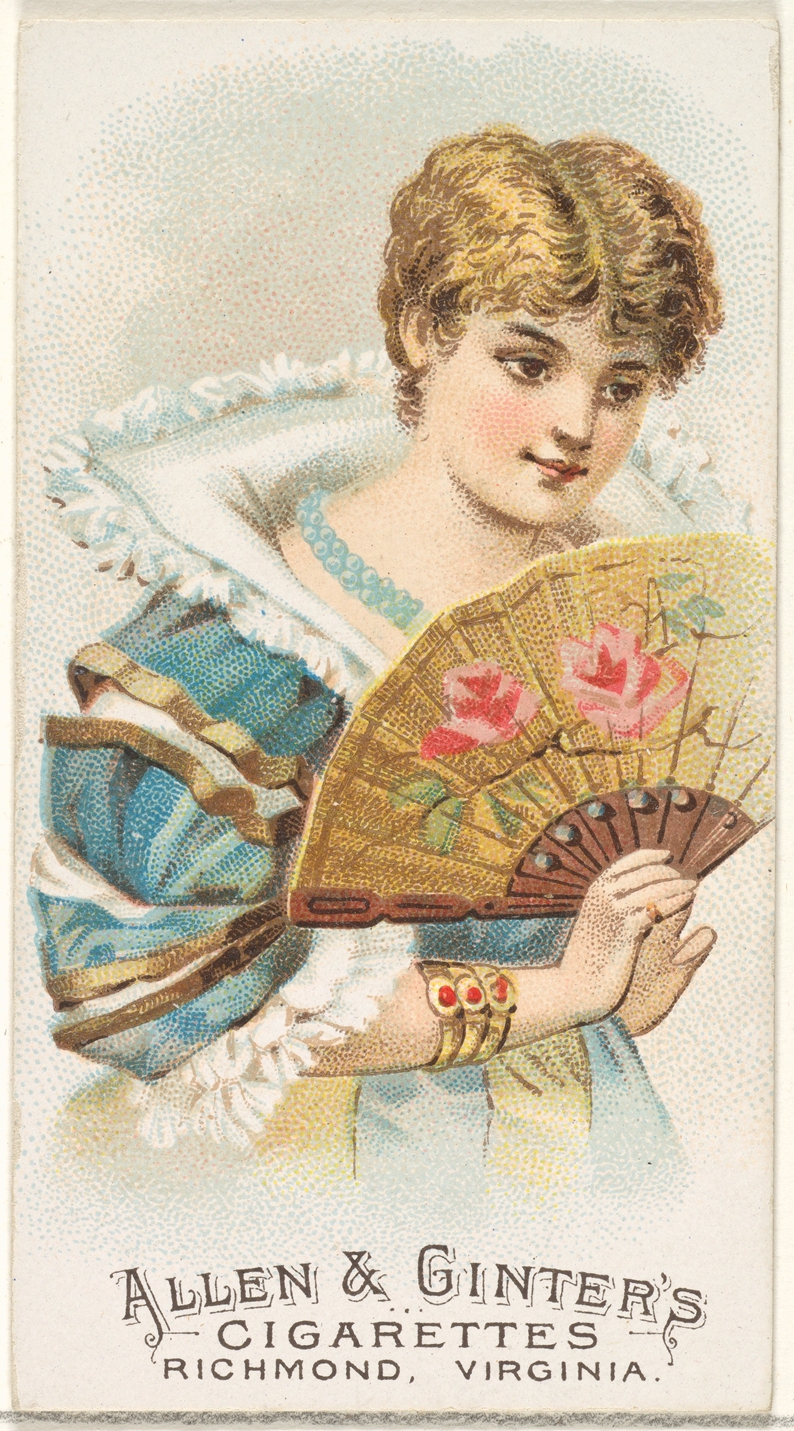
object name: print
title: Plate 14, from the Fans of the Period series (N7) for Allen & Ginter Cigarettes Brands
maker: allen & ginter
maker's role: publisher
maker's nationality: american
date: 1889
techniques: color lithograph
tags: fans,women